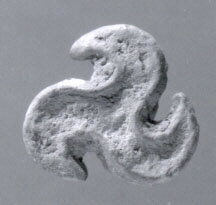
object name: stamp seal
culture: bactria-margiana archaeological complex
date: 2333-1668 BCE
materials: copper alloy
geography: bactria-margiana